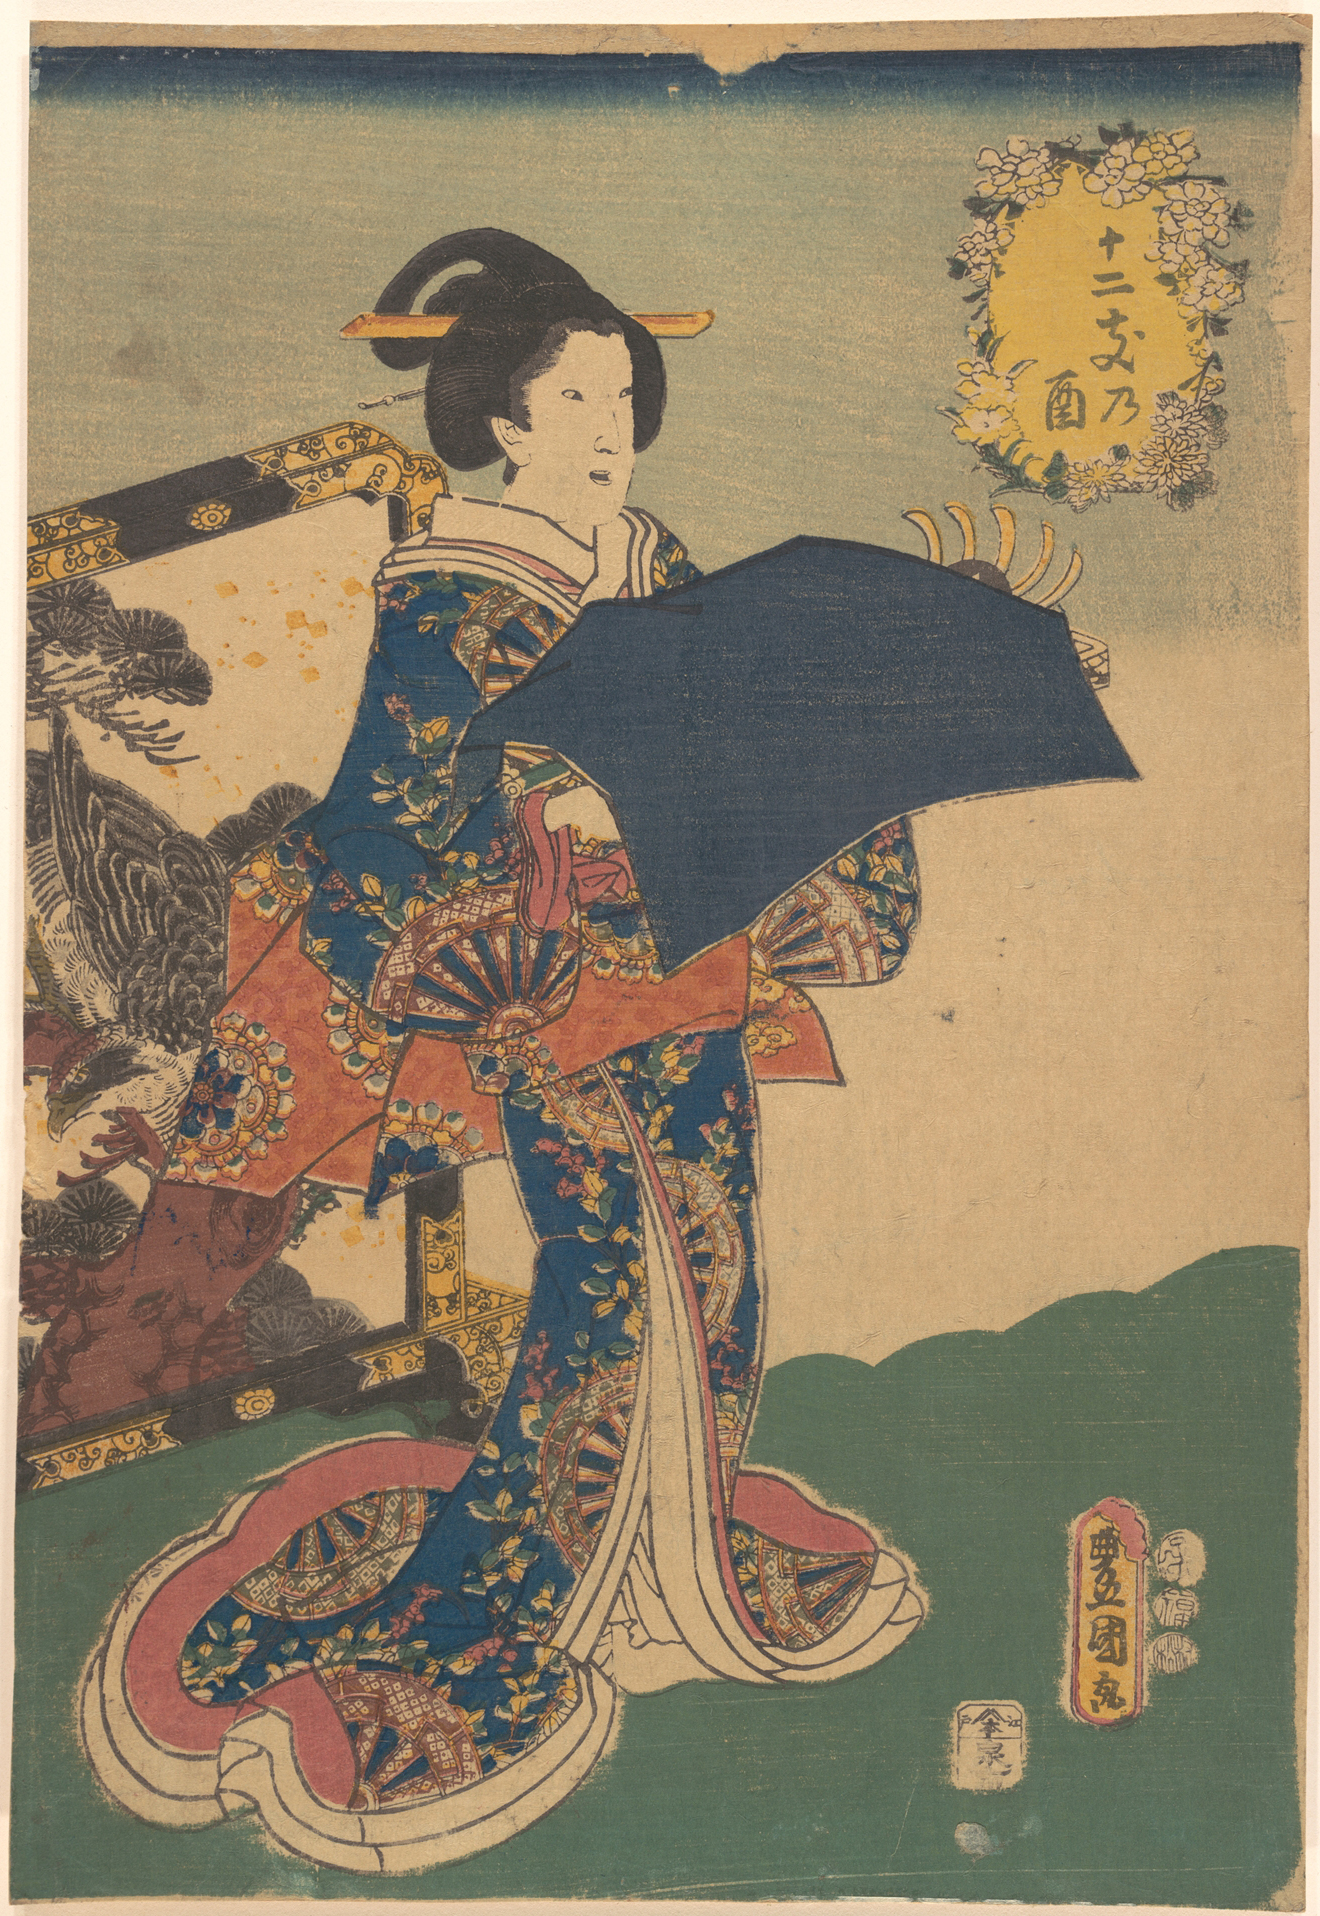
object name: print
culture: japanese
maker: utagawa kunisada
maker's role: artist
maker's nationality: japanese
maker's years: 1786-1864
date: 1786-1854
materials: ink, paper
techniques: woodblock print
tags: birds,women